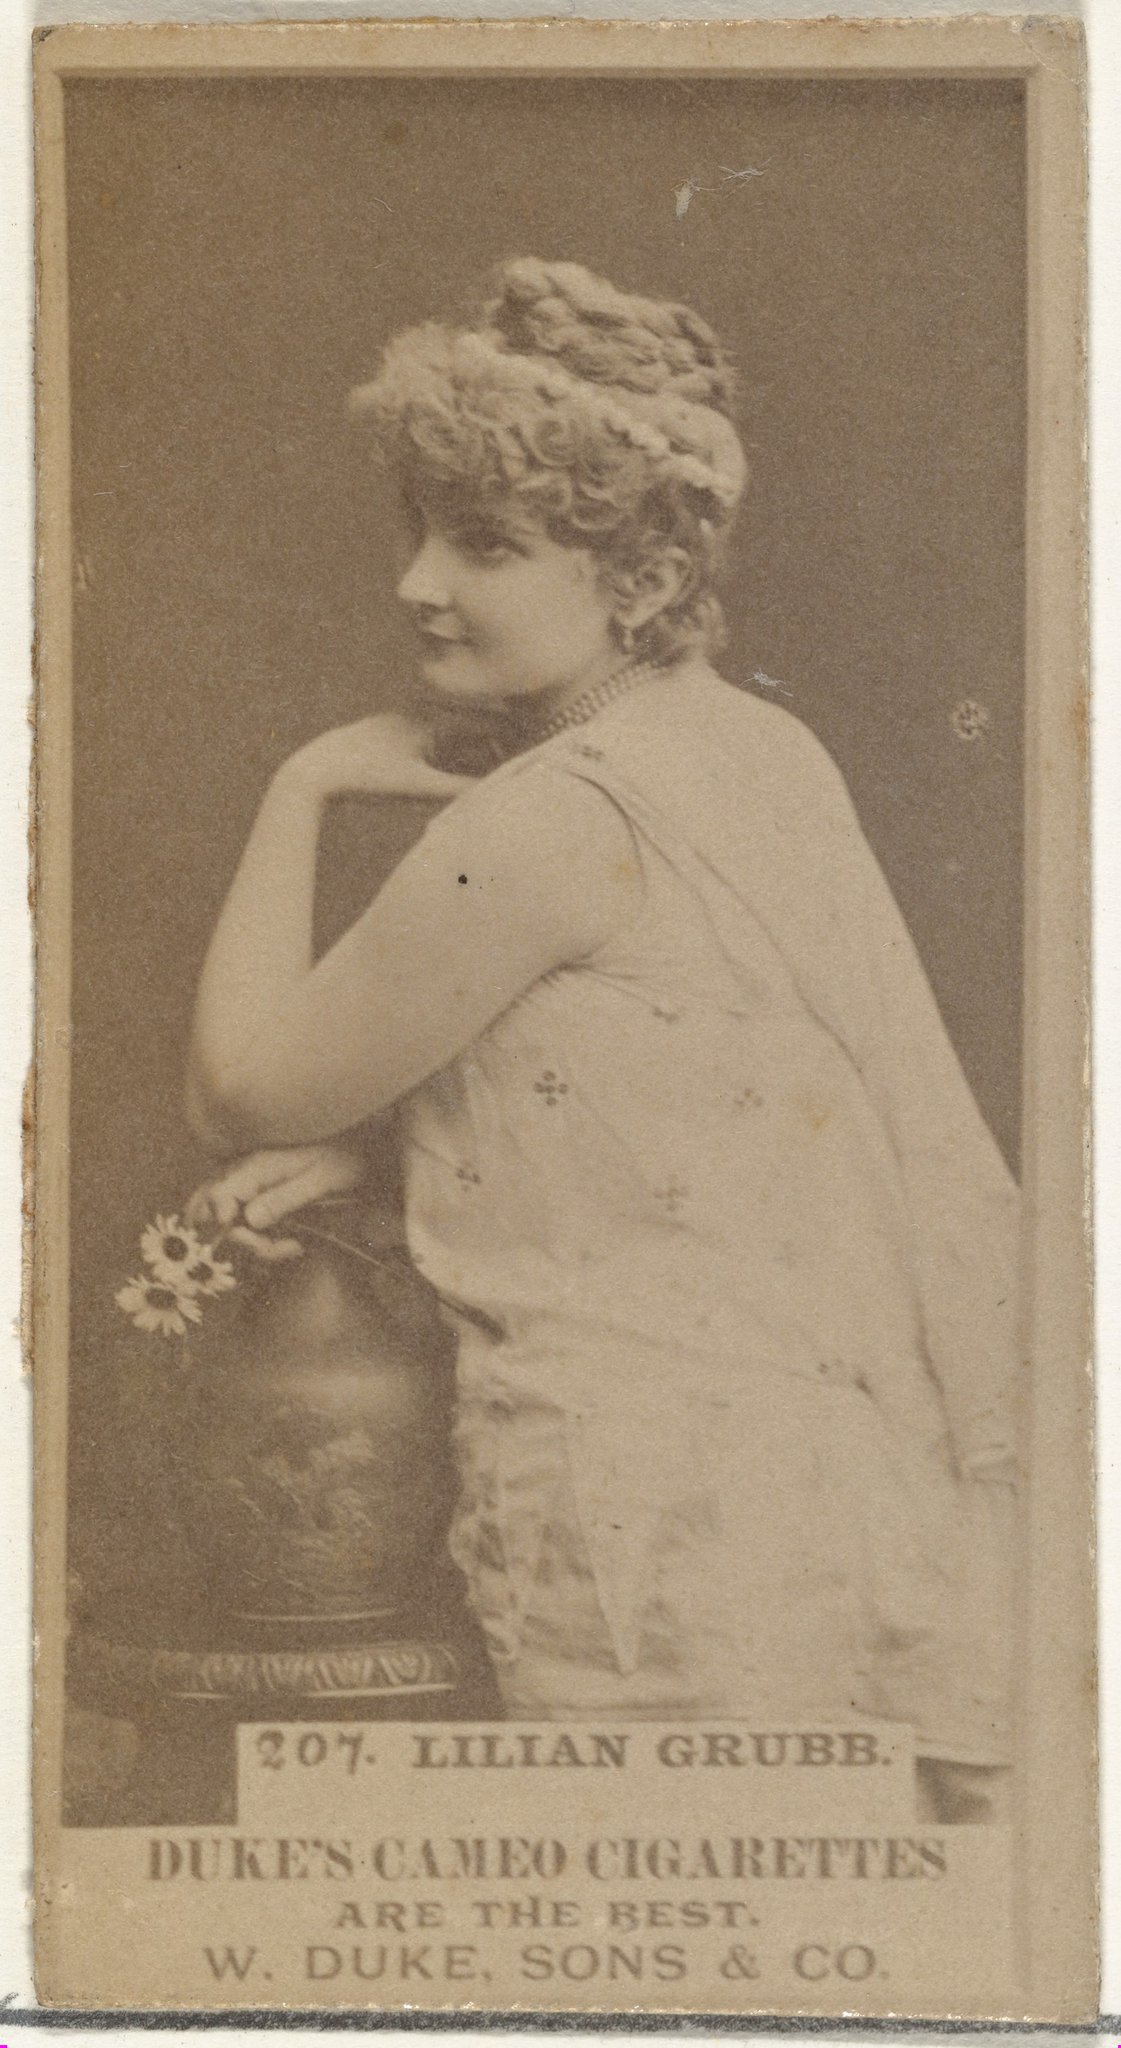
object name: photograph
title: Card Number 207, Lilian Grubb, from the Actors and Actresses series (N145-5) issued by Duke Sons & Co. to promote Cameo Cigarettes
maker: w. duke, sons & co.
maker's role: publisher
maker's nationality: american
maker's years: 1870-1920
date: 1880-1889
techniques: albumen silver print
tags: women,actresses